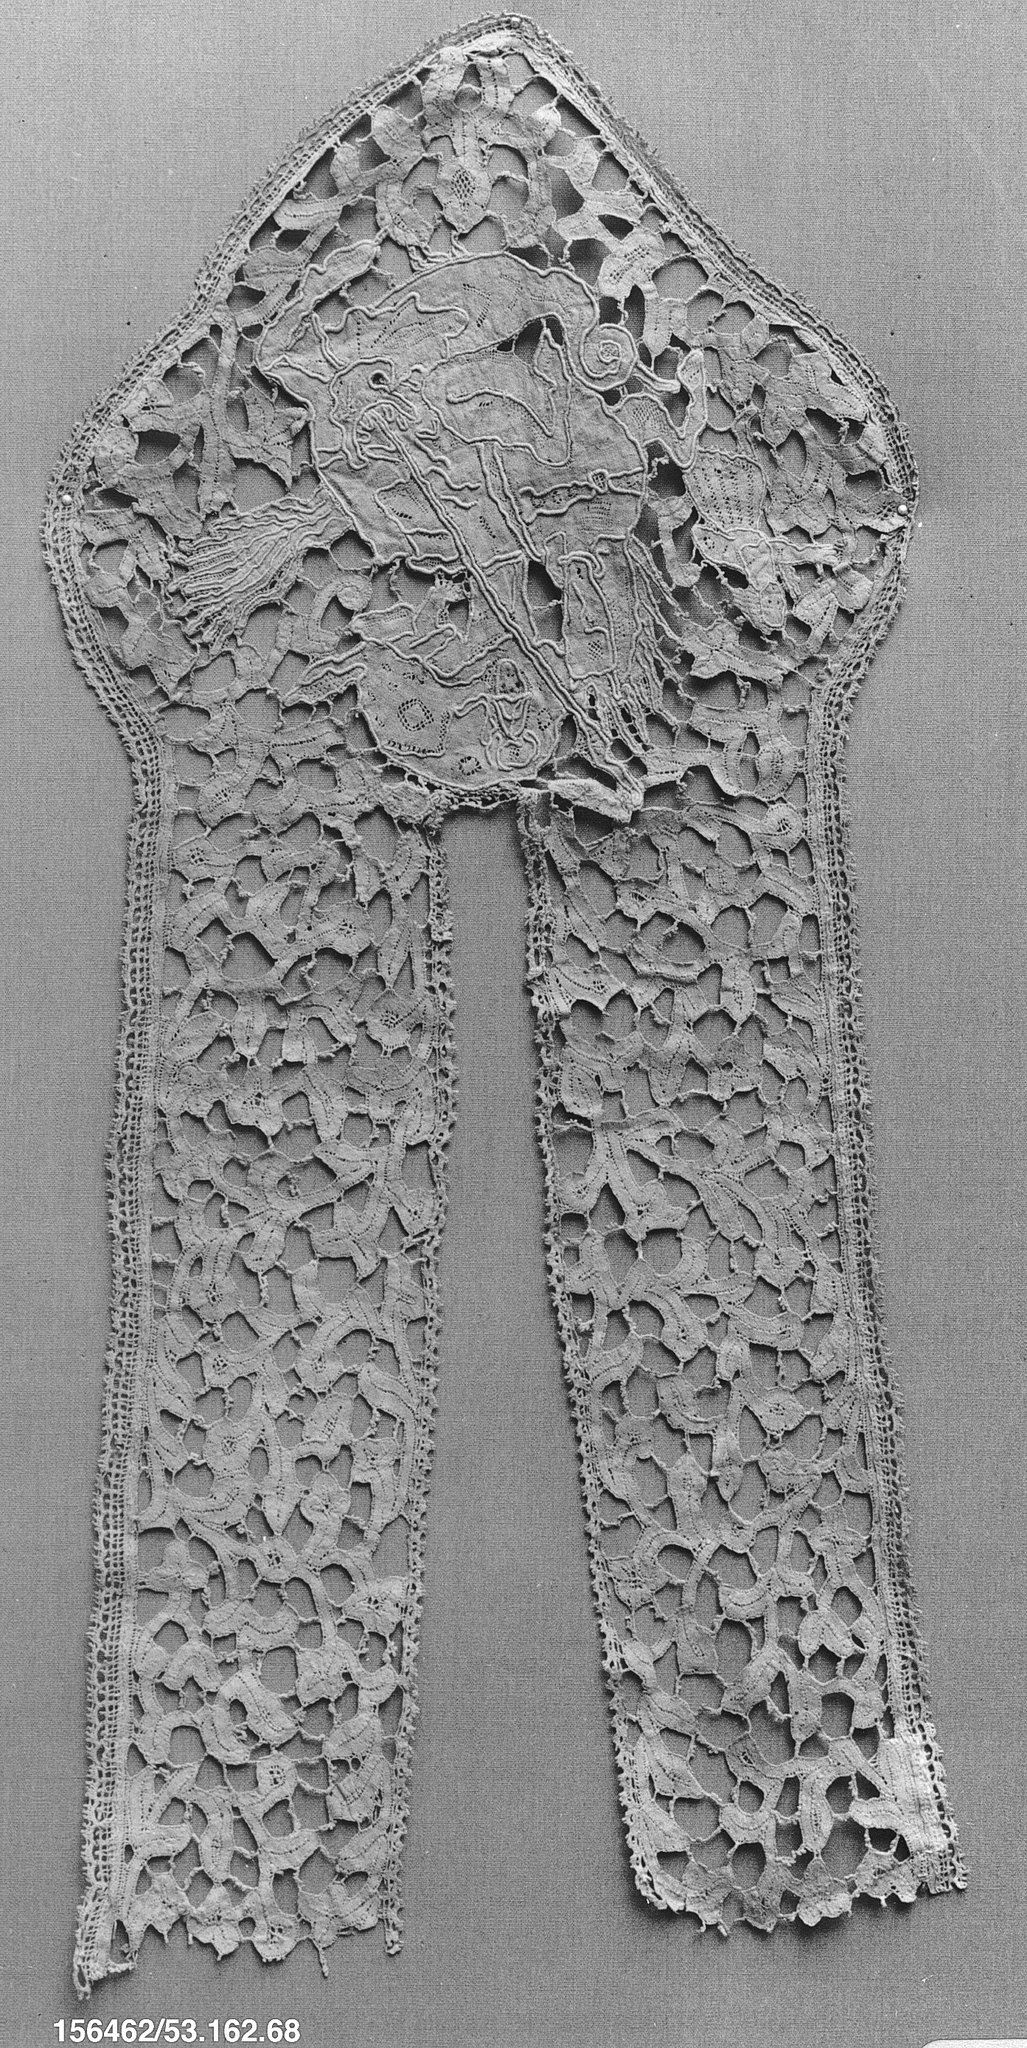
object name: alb decoration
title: Decoration from an alb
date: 1667-1700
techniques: lace